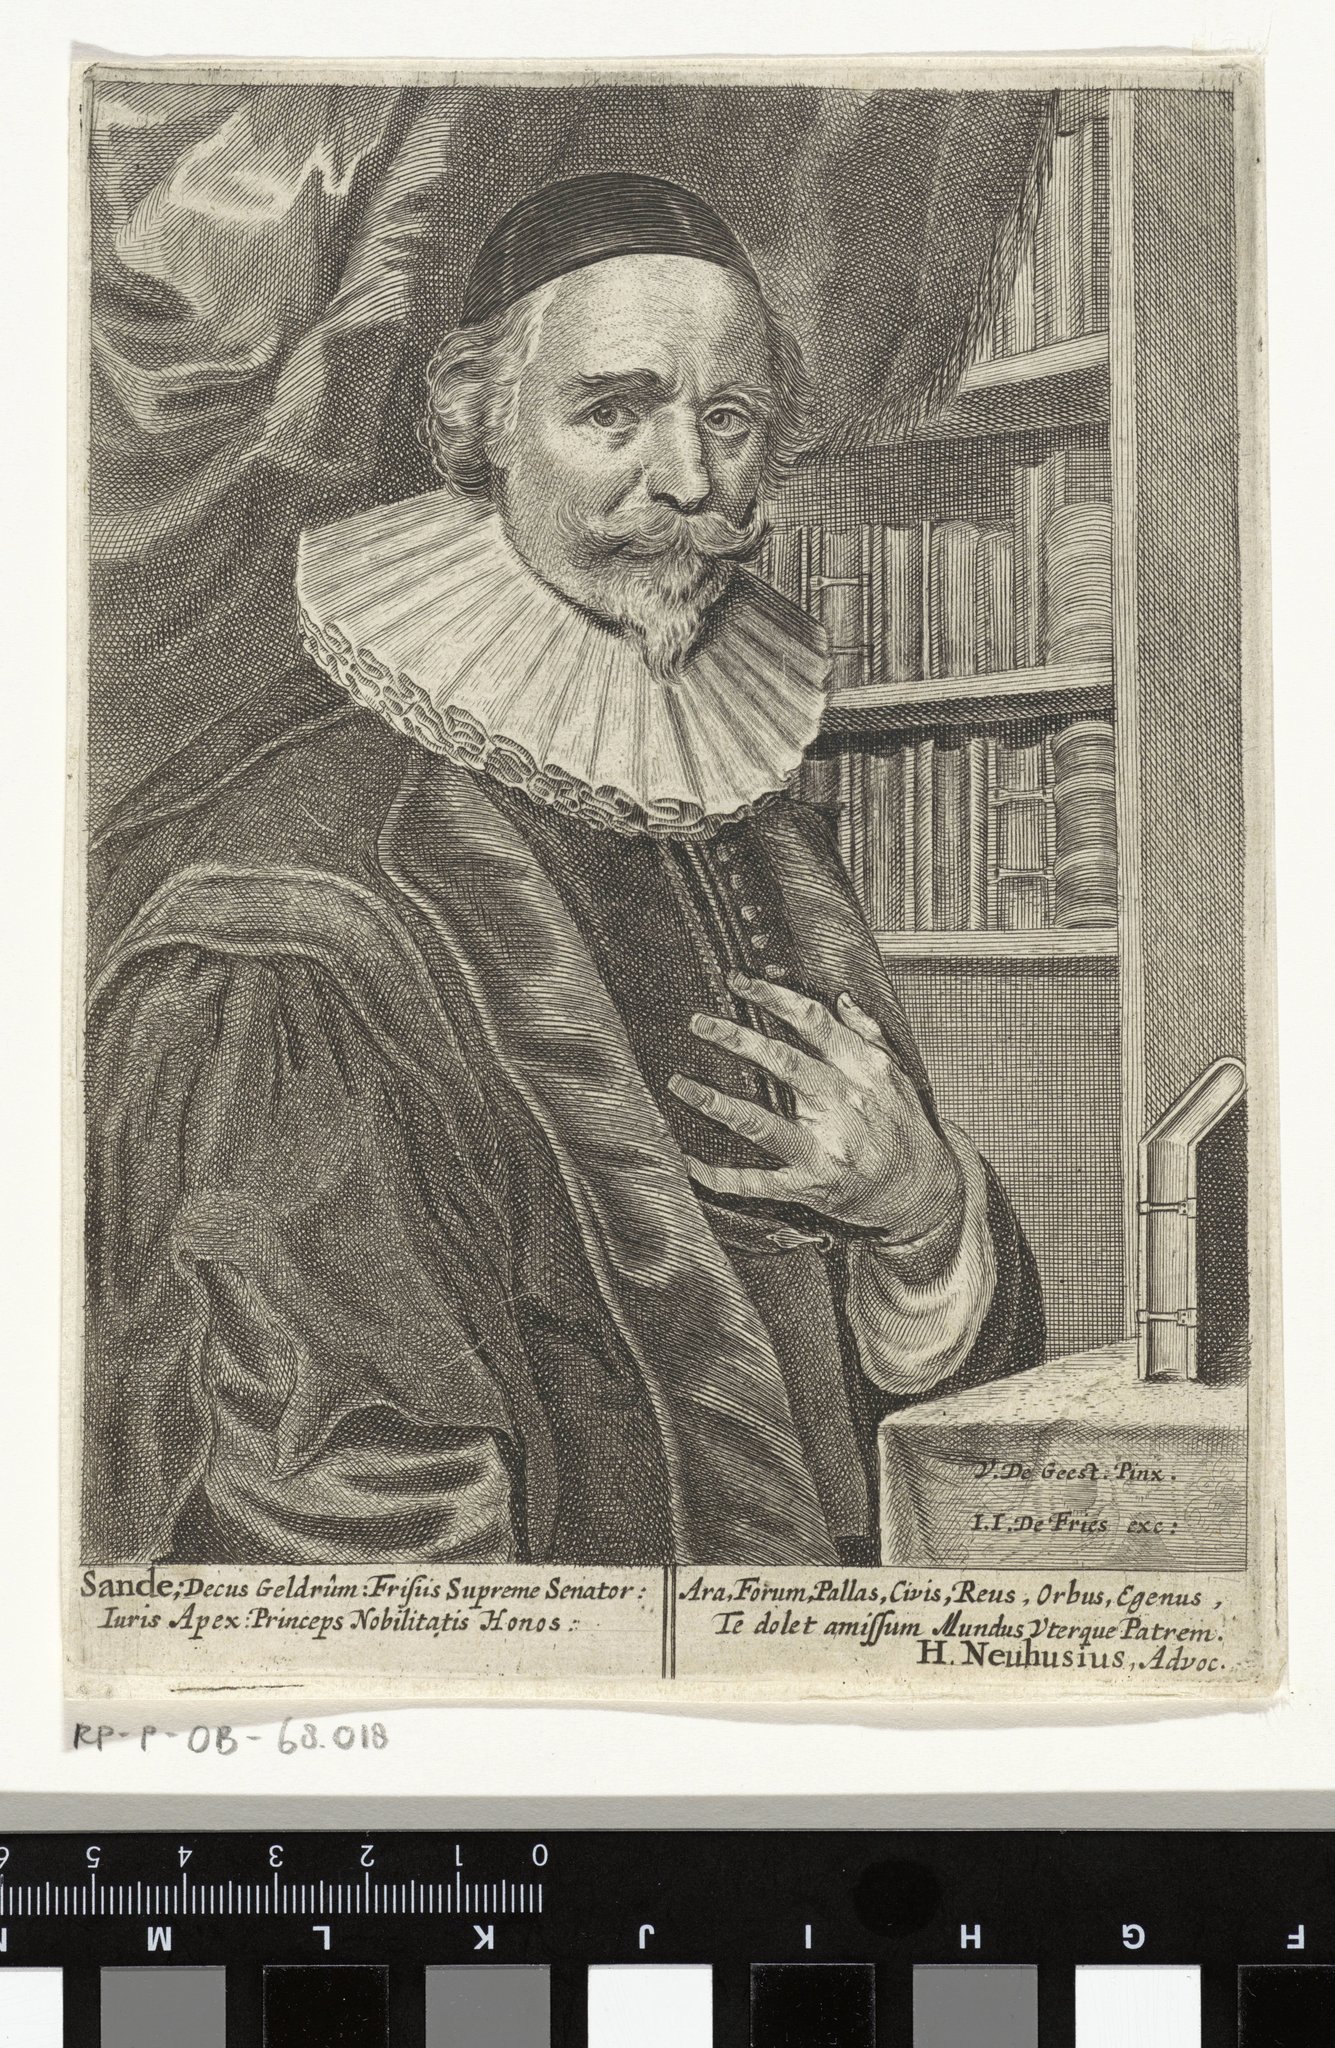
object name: print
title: Portret van Johan van den Sande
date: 1633-1639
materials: paper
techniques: engraving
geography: leeuwarden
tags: johan van den sande, bookshelves, historical persons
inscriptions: collector's mark: Lugt 2228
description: Portret van Johan van den Sande voor een boekenkast. Zijn linkerhand houdt hij voor zijn borst. Onder in de marge een vierregelig onderschrift in het Latijn. Dit auteursportret werd gebruikt voor Van de Sande's publicatie 'Decisiones Frisicae sive Rerum in suprema Frisiorum curia judicatarum', deel 5, 1639.